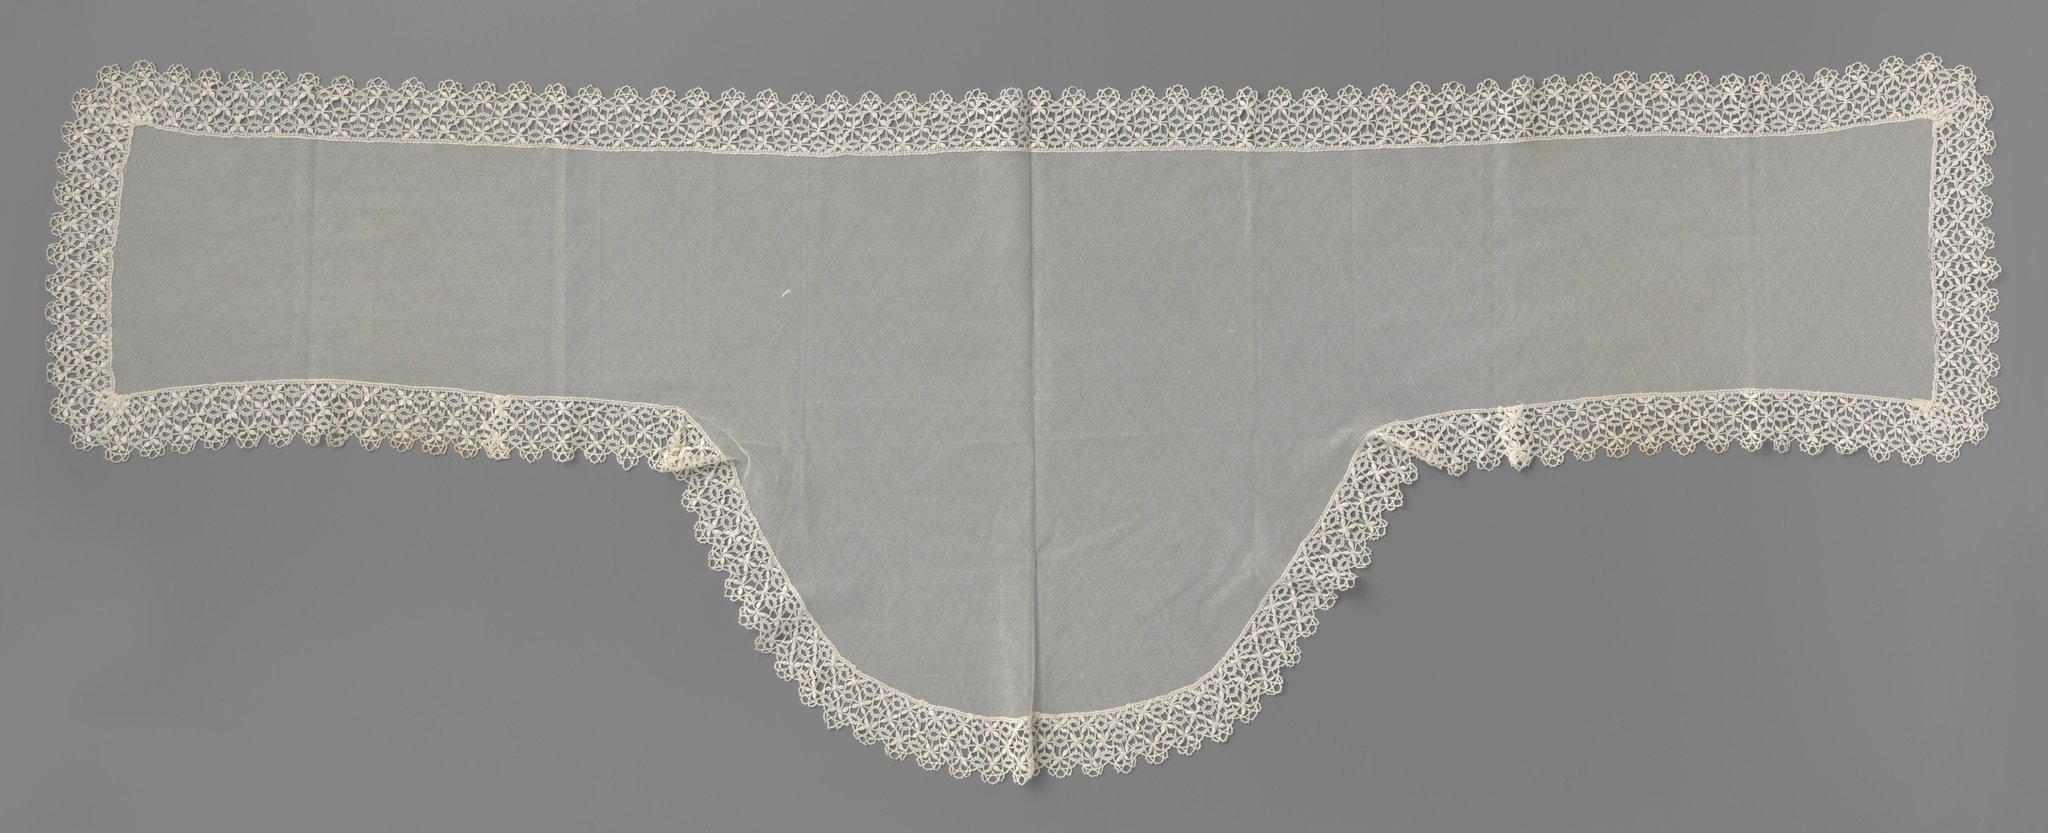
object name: fichu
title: Fichu van machinale tule met een rand kloskant met sterretjes en kransjes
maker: Anonymous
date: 1925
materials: linen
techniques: lace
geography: netherlands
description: Fichu van naturelkleurige machinale tule met een rand van naturelkleurig kloskant, Cluny-kant. Langwerpig rechthoekig model, met een halfcirkelvormige verbreding aan één lange zijde. Het patroon van de gekloste rand bestaat uit drie verspringende rijen van sterren en ovale kransjes. Elke ster bestaat uit vier 'stralen' of blaadjes gemaakt in vormslag, de kransjes zijn gemaakt met een vierkante tralie. Ze zijn met elkaar verbonden door een vlechtengrond. De schulpenrand langs de buitenzijde bestaat uit boogjes waaraan met gepicoteerde vlechtjes steeds drie kleinere boogjes gemaakt zijn.